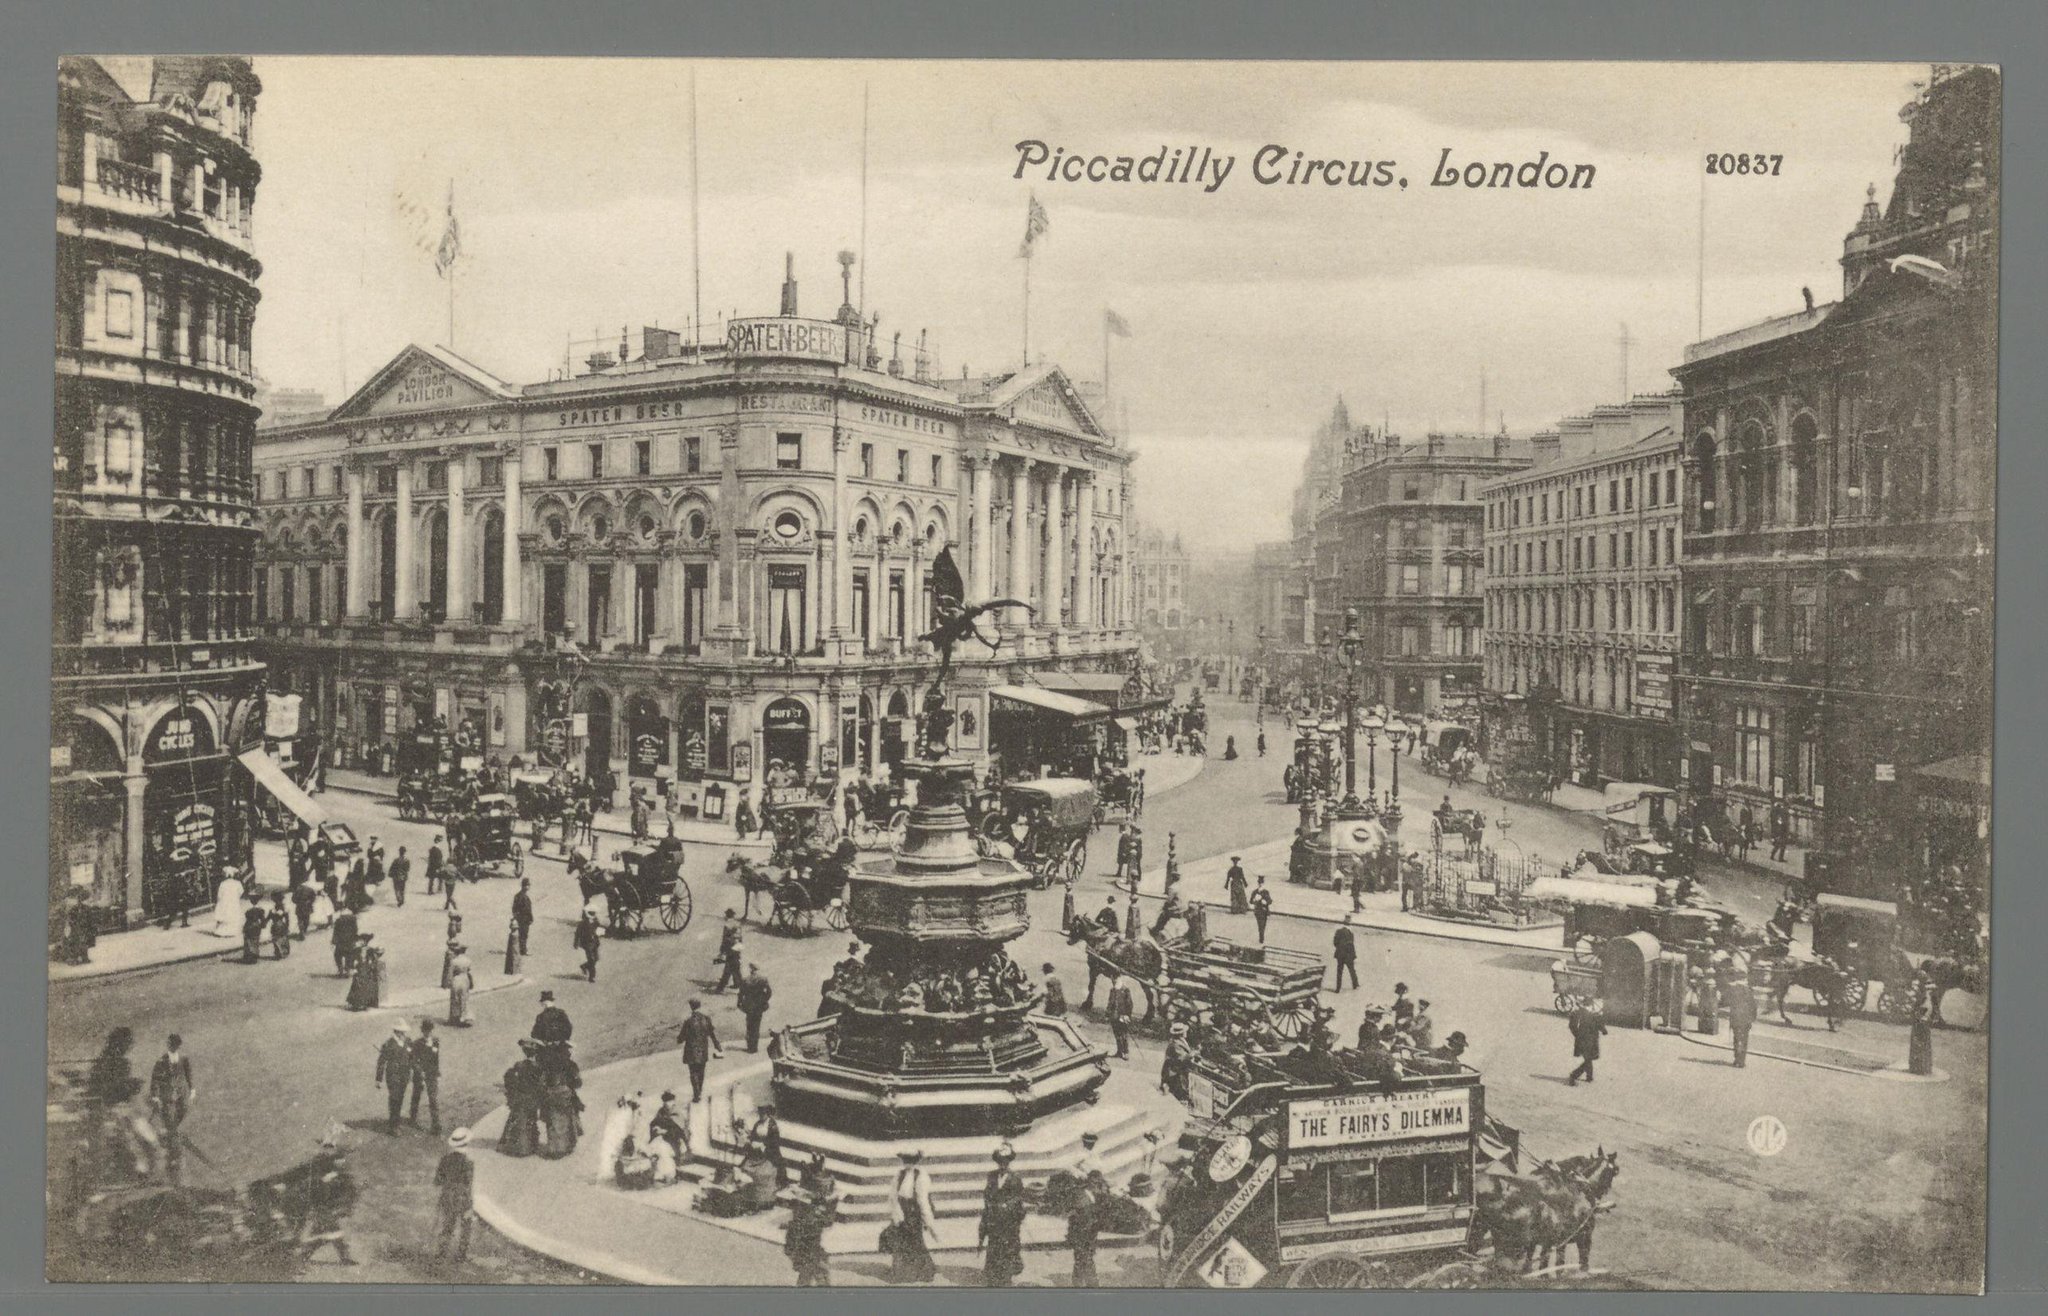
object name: photomechanical print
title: Piccadilly Circus, London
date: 1902-1930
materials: cardboard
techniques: photograph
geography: great britain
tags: square, place, circus, etc., monument, statue